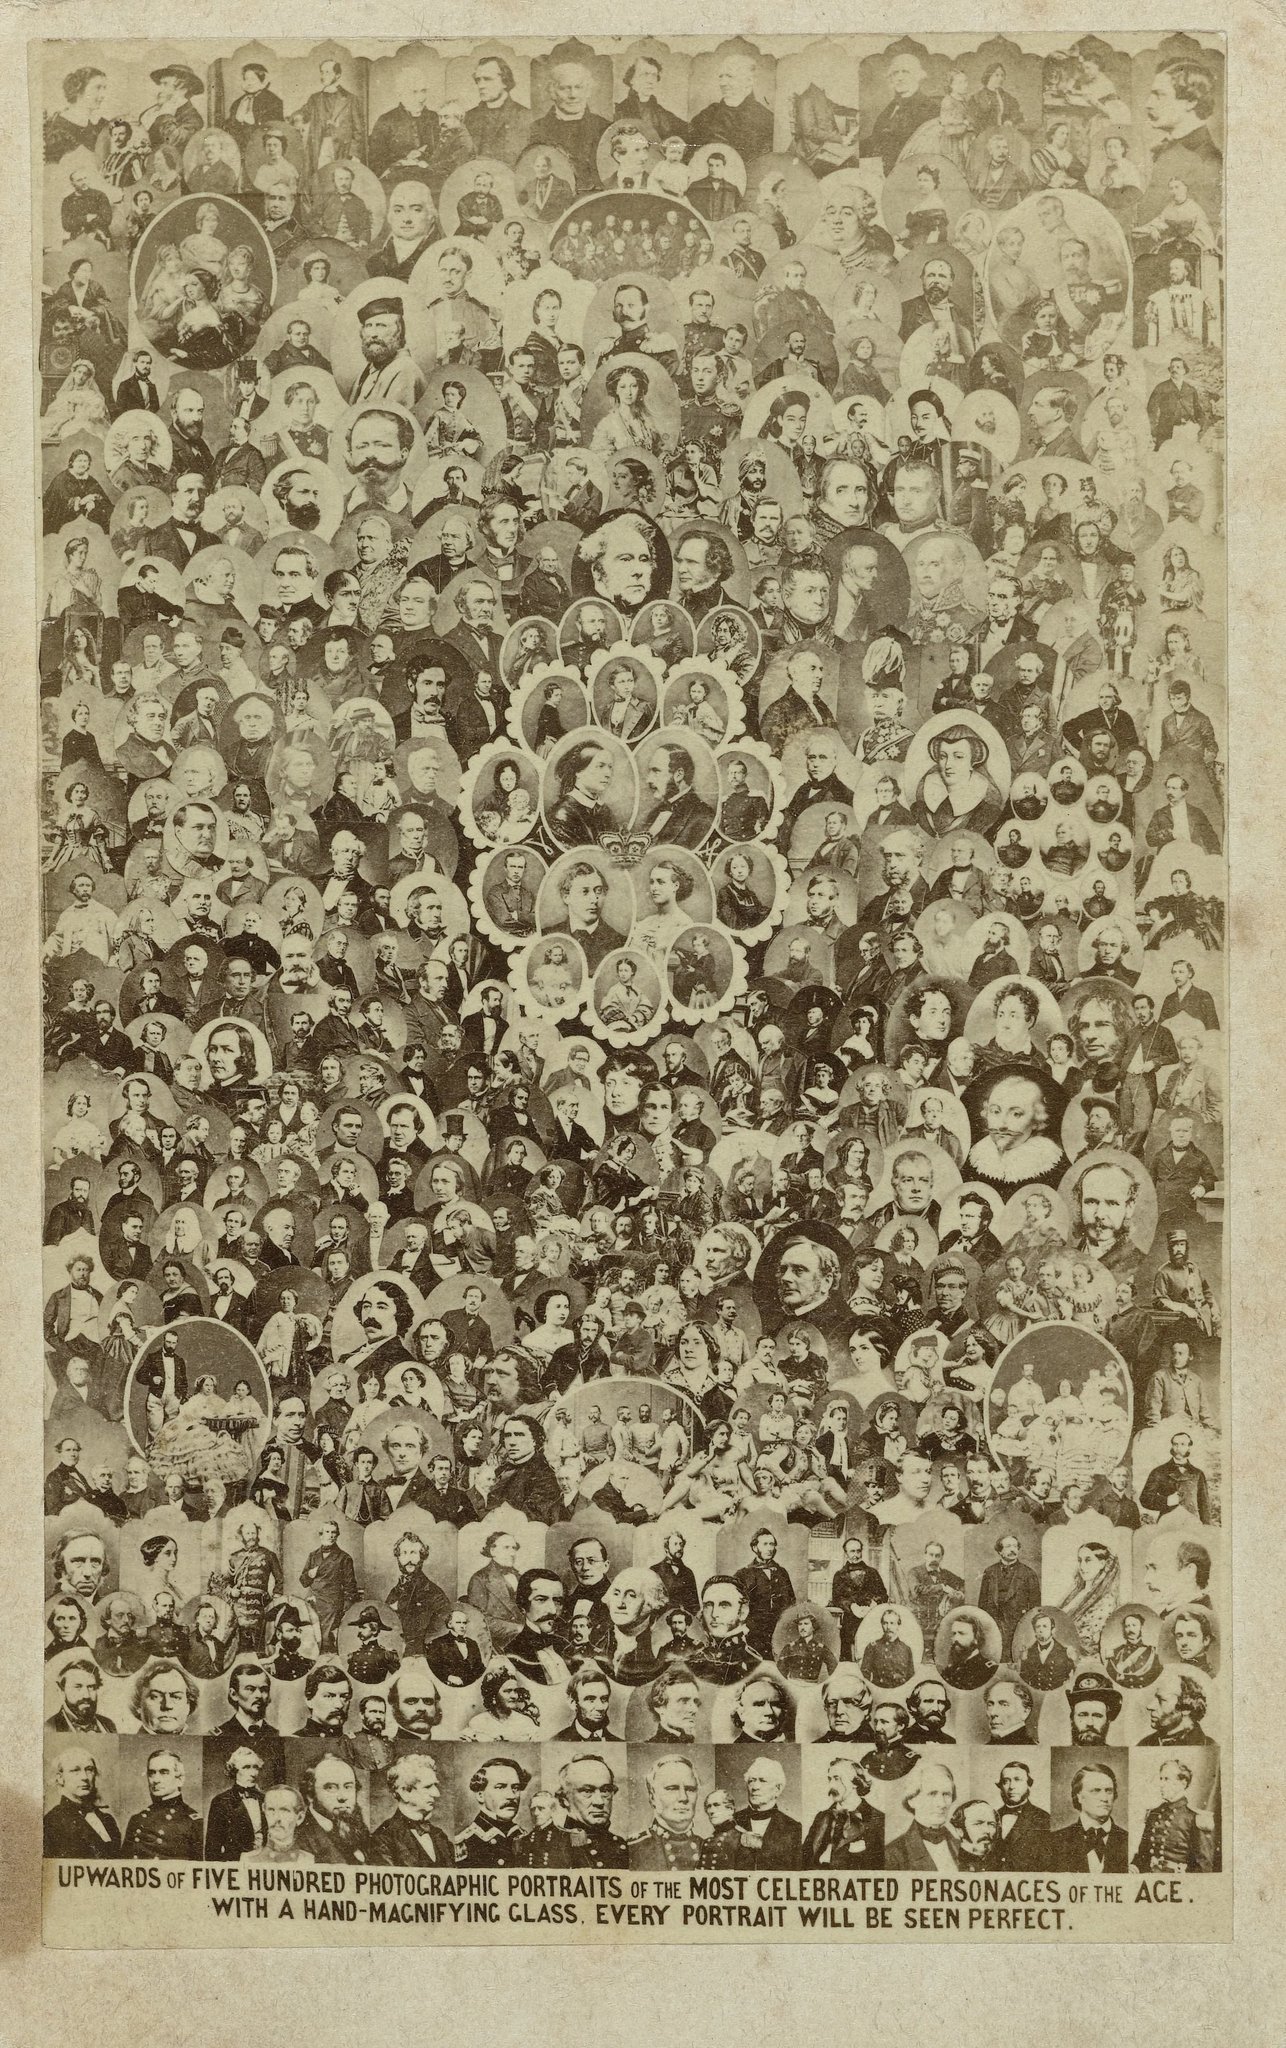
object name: carte de visite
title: Portretten van bekende personen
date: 1862-1863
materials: cardboard, paper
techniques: albumen print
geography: london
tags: victoria (koningin van het verenigd koninkrijk en keizerin van india), london, napoleon iii (keizer der fransen), brussels, willem iii (koning der nederlanden), historical persons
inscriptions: address: ‘ASHFORD, BROTHERS & CO. // PHOTOGRAPHIC PUBLISHERS, // 76, NEWGATE STREET, // LONDON.’, annotation: ‘UPWARDS OF FIVE HUNDRED PHOTOGRAPHIC PORTRAITS OF THE MOST CELEBRATED PERSONAGES OF THE AGE. // WITH A HAND-MAGNIFYING GLASS, EVERY PORTRAIT WILL BE SEEN PERFECT.’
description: Compositie van meer dan 500 portretten van bekende personen, onder wie leden van de Britse Koninklijke familie (Victoria, Albert en hun kinderen), George Washington, Abraham Lincoln, Giuseppe Garibaldi, koning Willem III (Nederland), Camillo Benso conte di Cavour, keizer Napoléon III, Ulysses S. Grant.